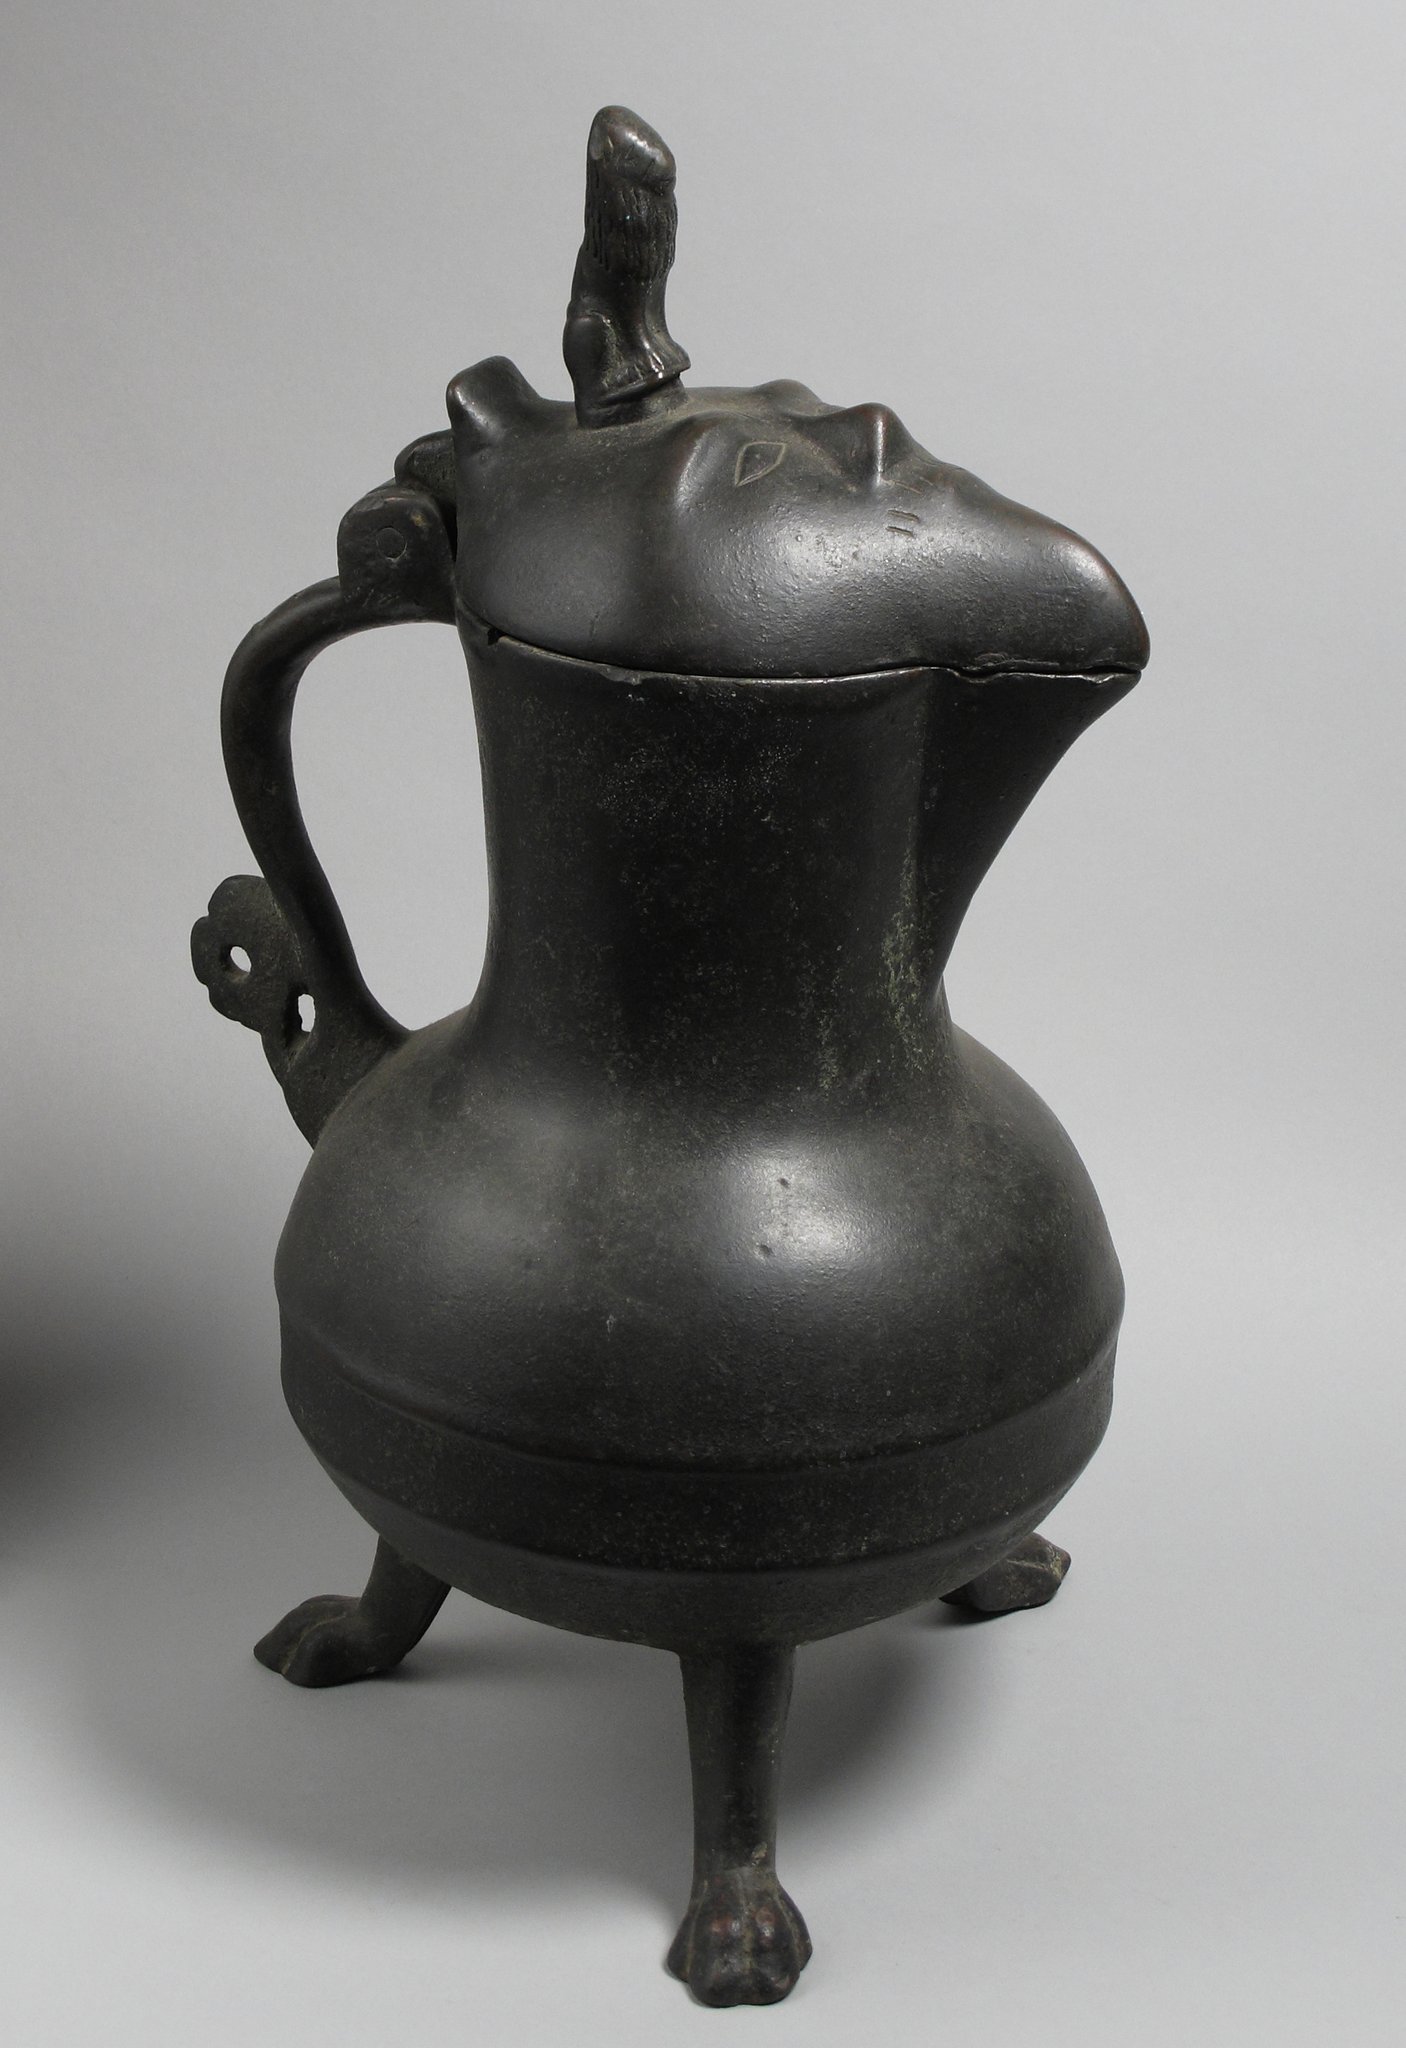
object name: jug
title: Covered Jug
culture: german or south netherlandish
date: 1367-1400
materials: copper alloy